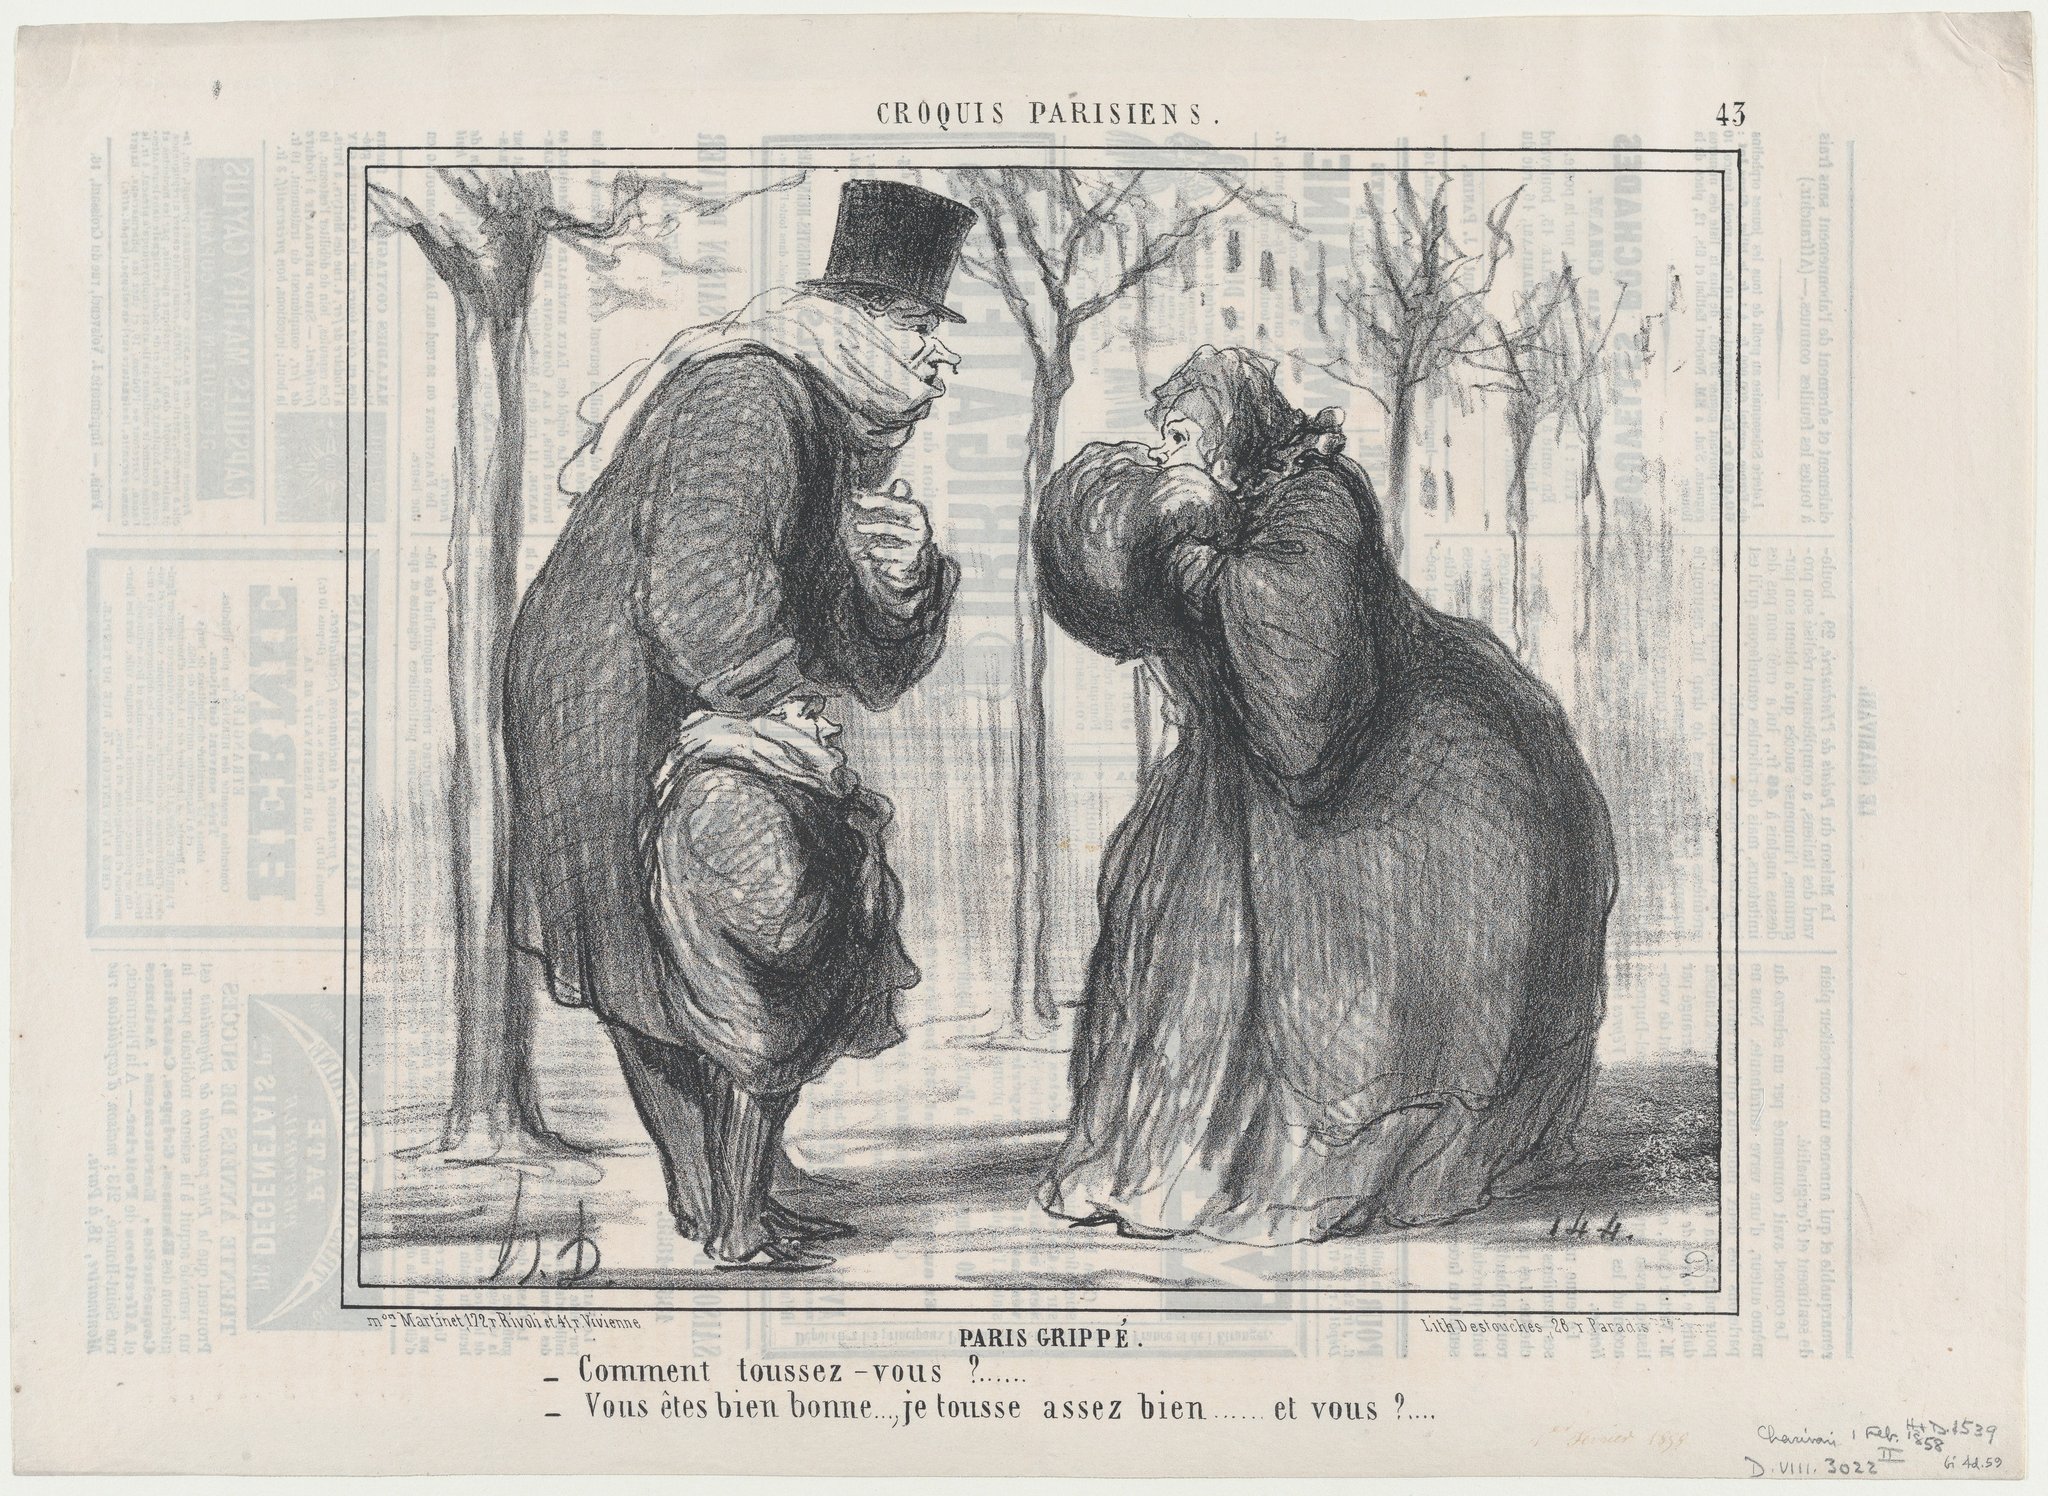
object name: print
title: Paris Grippé, from Croquis Parisiens, published in Le Charivari, February 1, 1858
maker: honoré daumier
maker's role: artist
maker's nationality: french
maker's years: 1808-1879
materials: paper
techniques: lithograph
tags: men,women